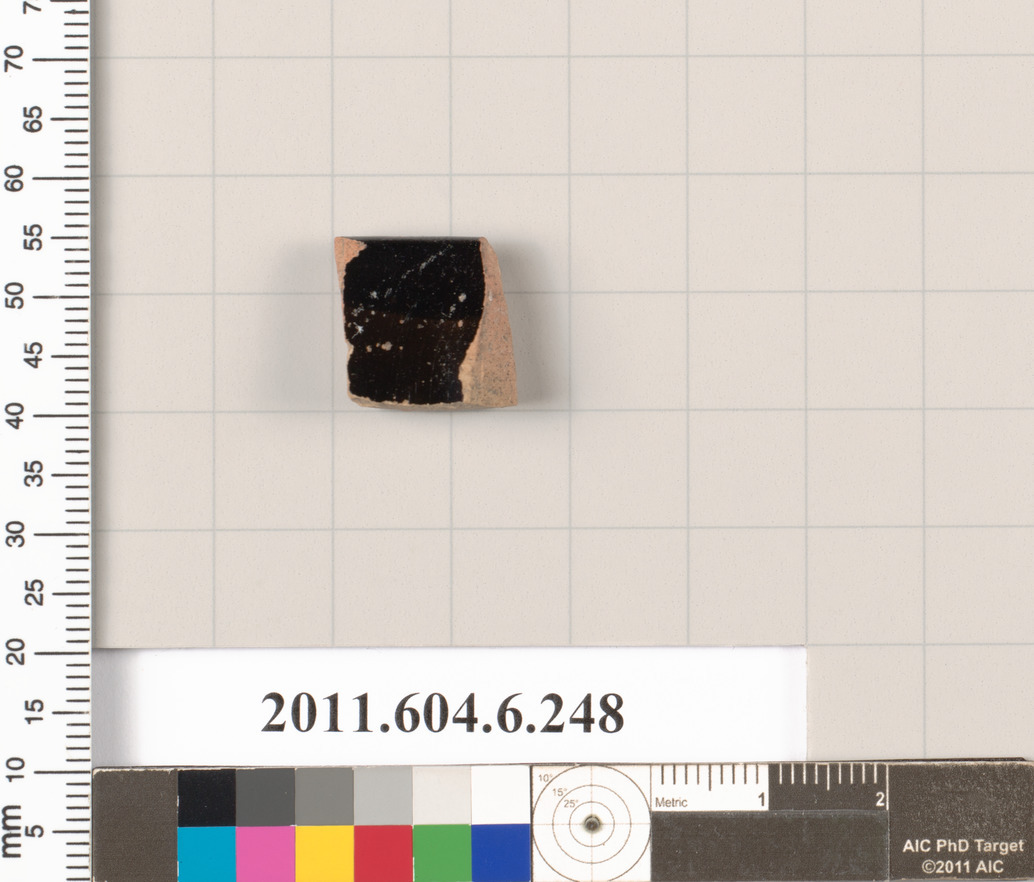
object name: undetermined open shape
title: Terracotta rim fragment of an open shape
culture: greek, attic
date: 600-301 BCE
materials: terracotta